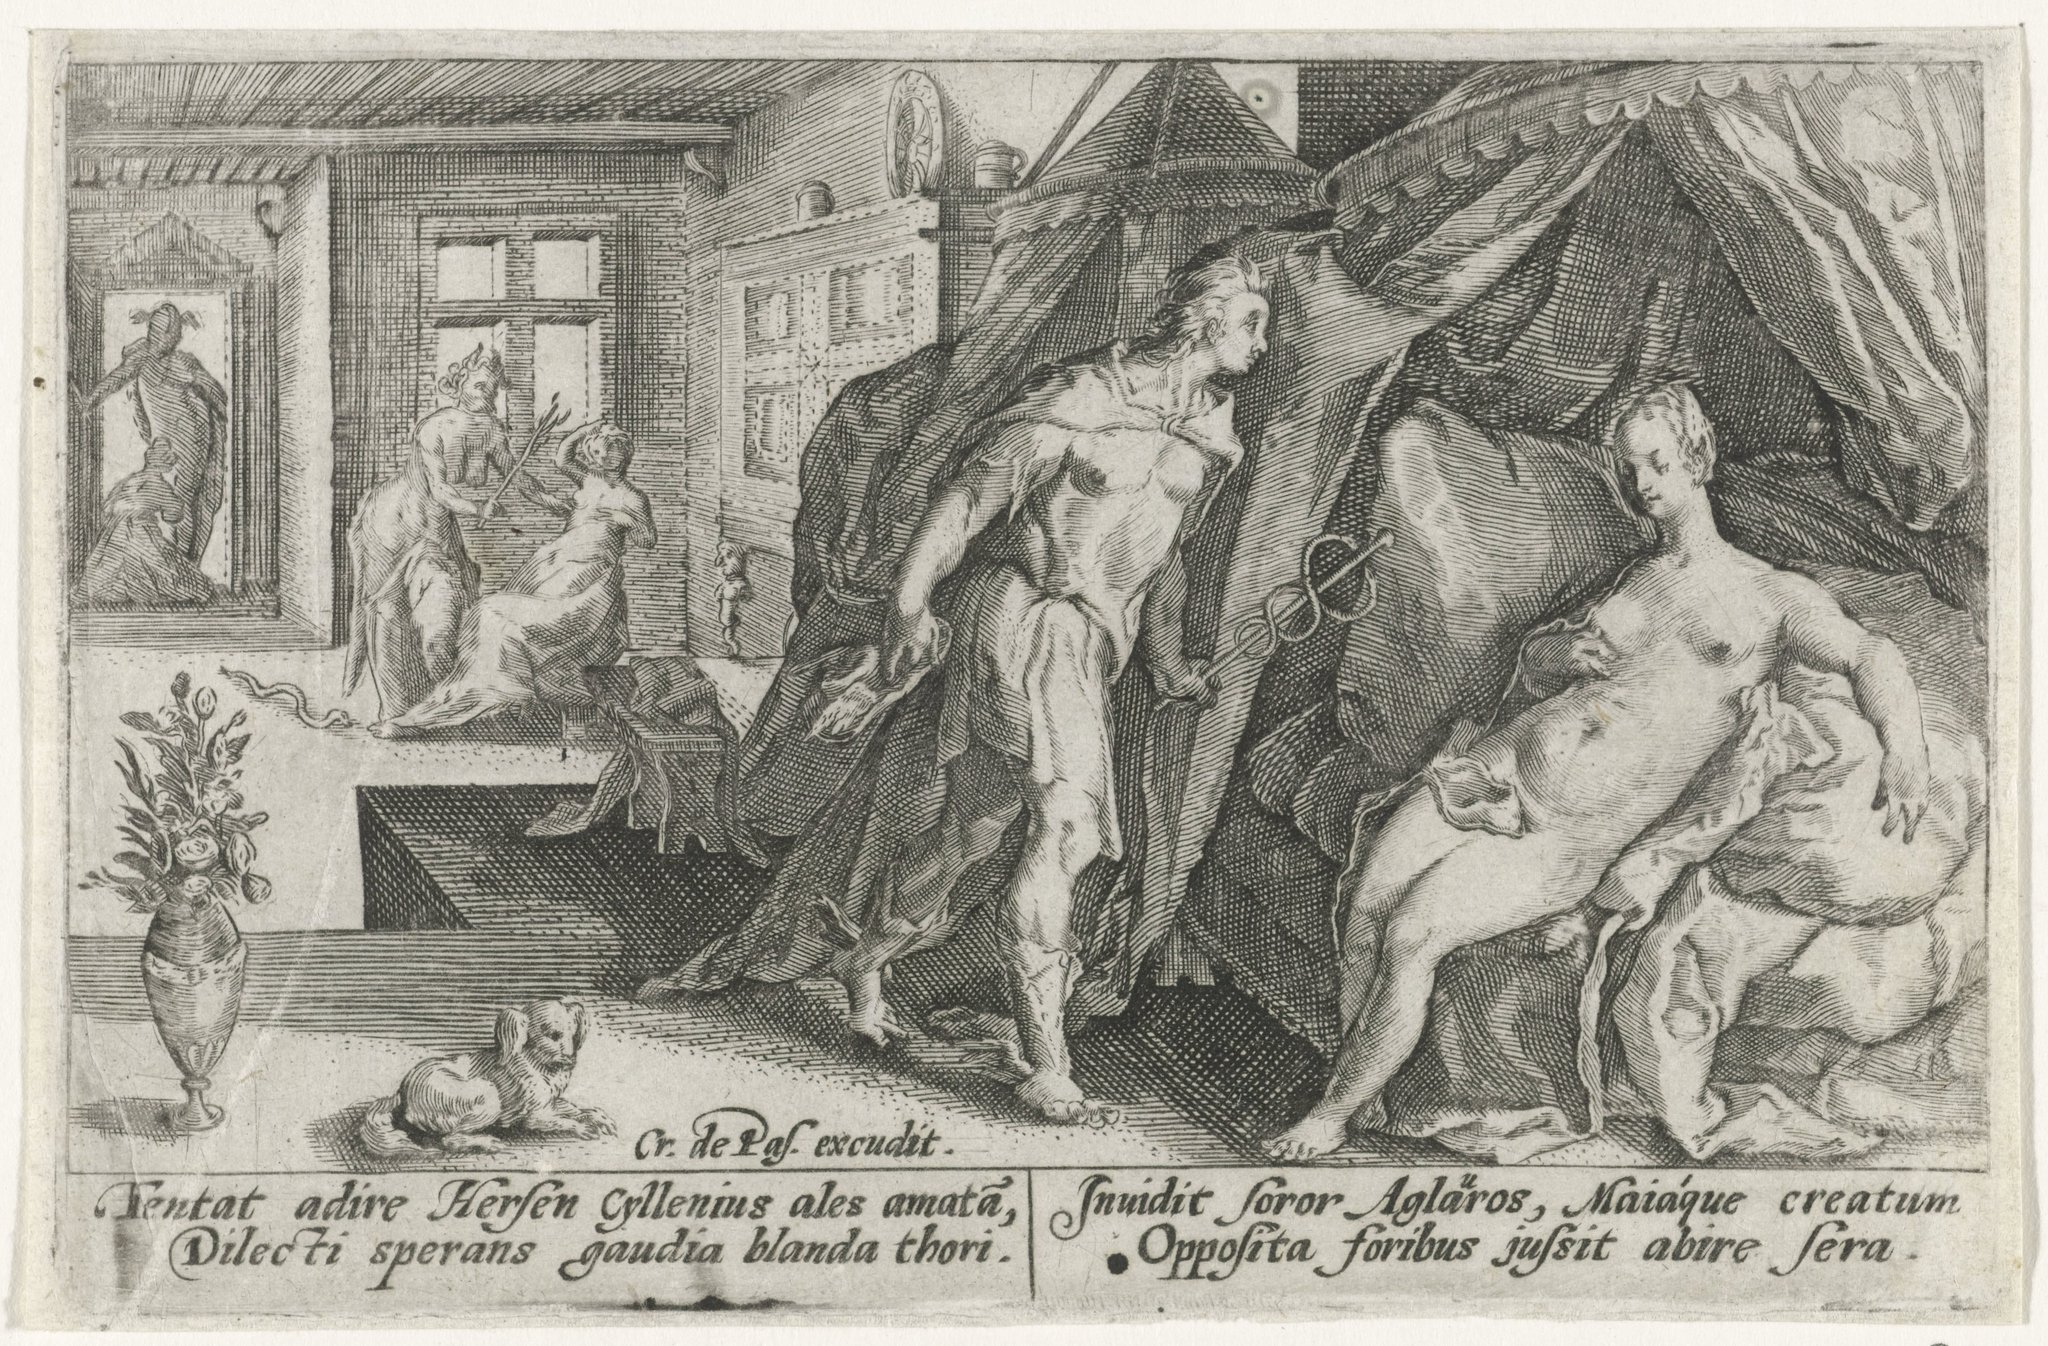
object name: print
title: Mercurius en Herse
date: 1602-1607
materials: paper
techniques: engraving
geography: cologne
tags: mercury tries to gain admission to herse's room, possibly by bribing aglauros, her sister, with gold (+ variant)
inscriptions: collector's mark: Lugt 2228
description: Mercurius betreedt de kamer van Herse, op wie hij verliefd is geworden. Op de achtergrond probeert Aglauros, de jaloerse zuster van Herse, Mercurius tegen te houden. In de marge een vierregelig onderschrift, in twee kolommen, in het Latijn.